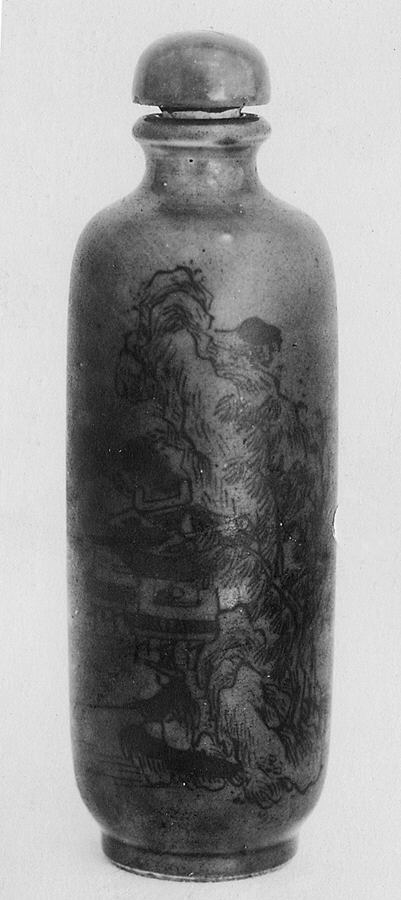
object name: snuff bottle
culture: chinese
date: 1736-1795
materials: porcelain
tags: landscapes